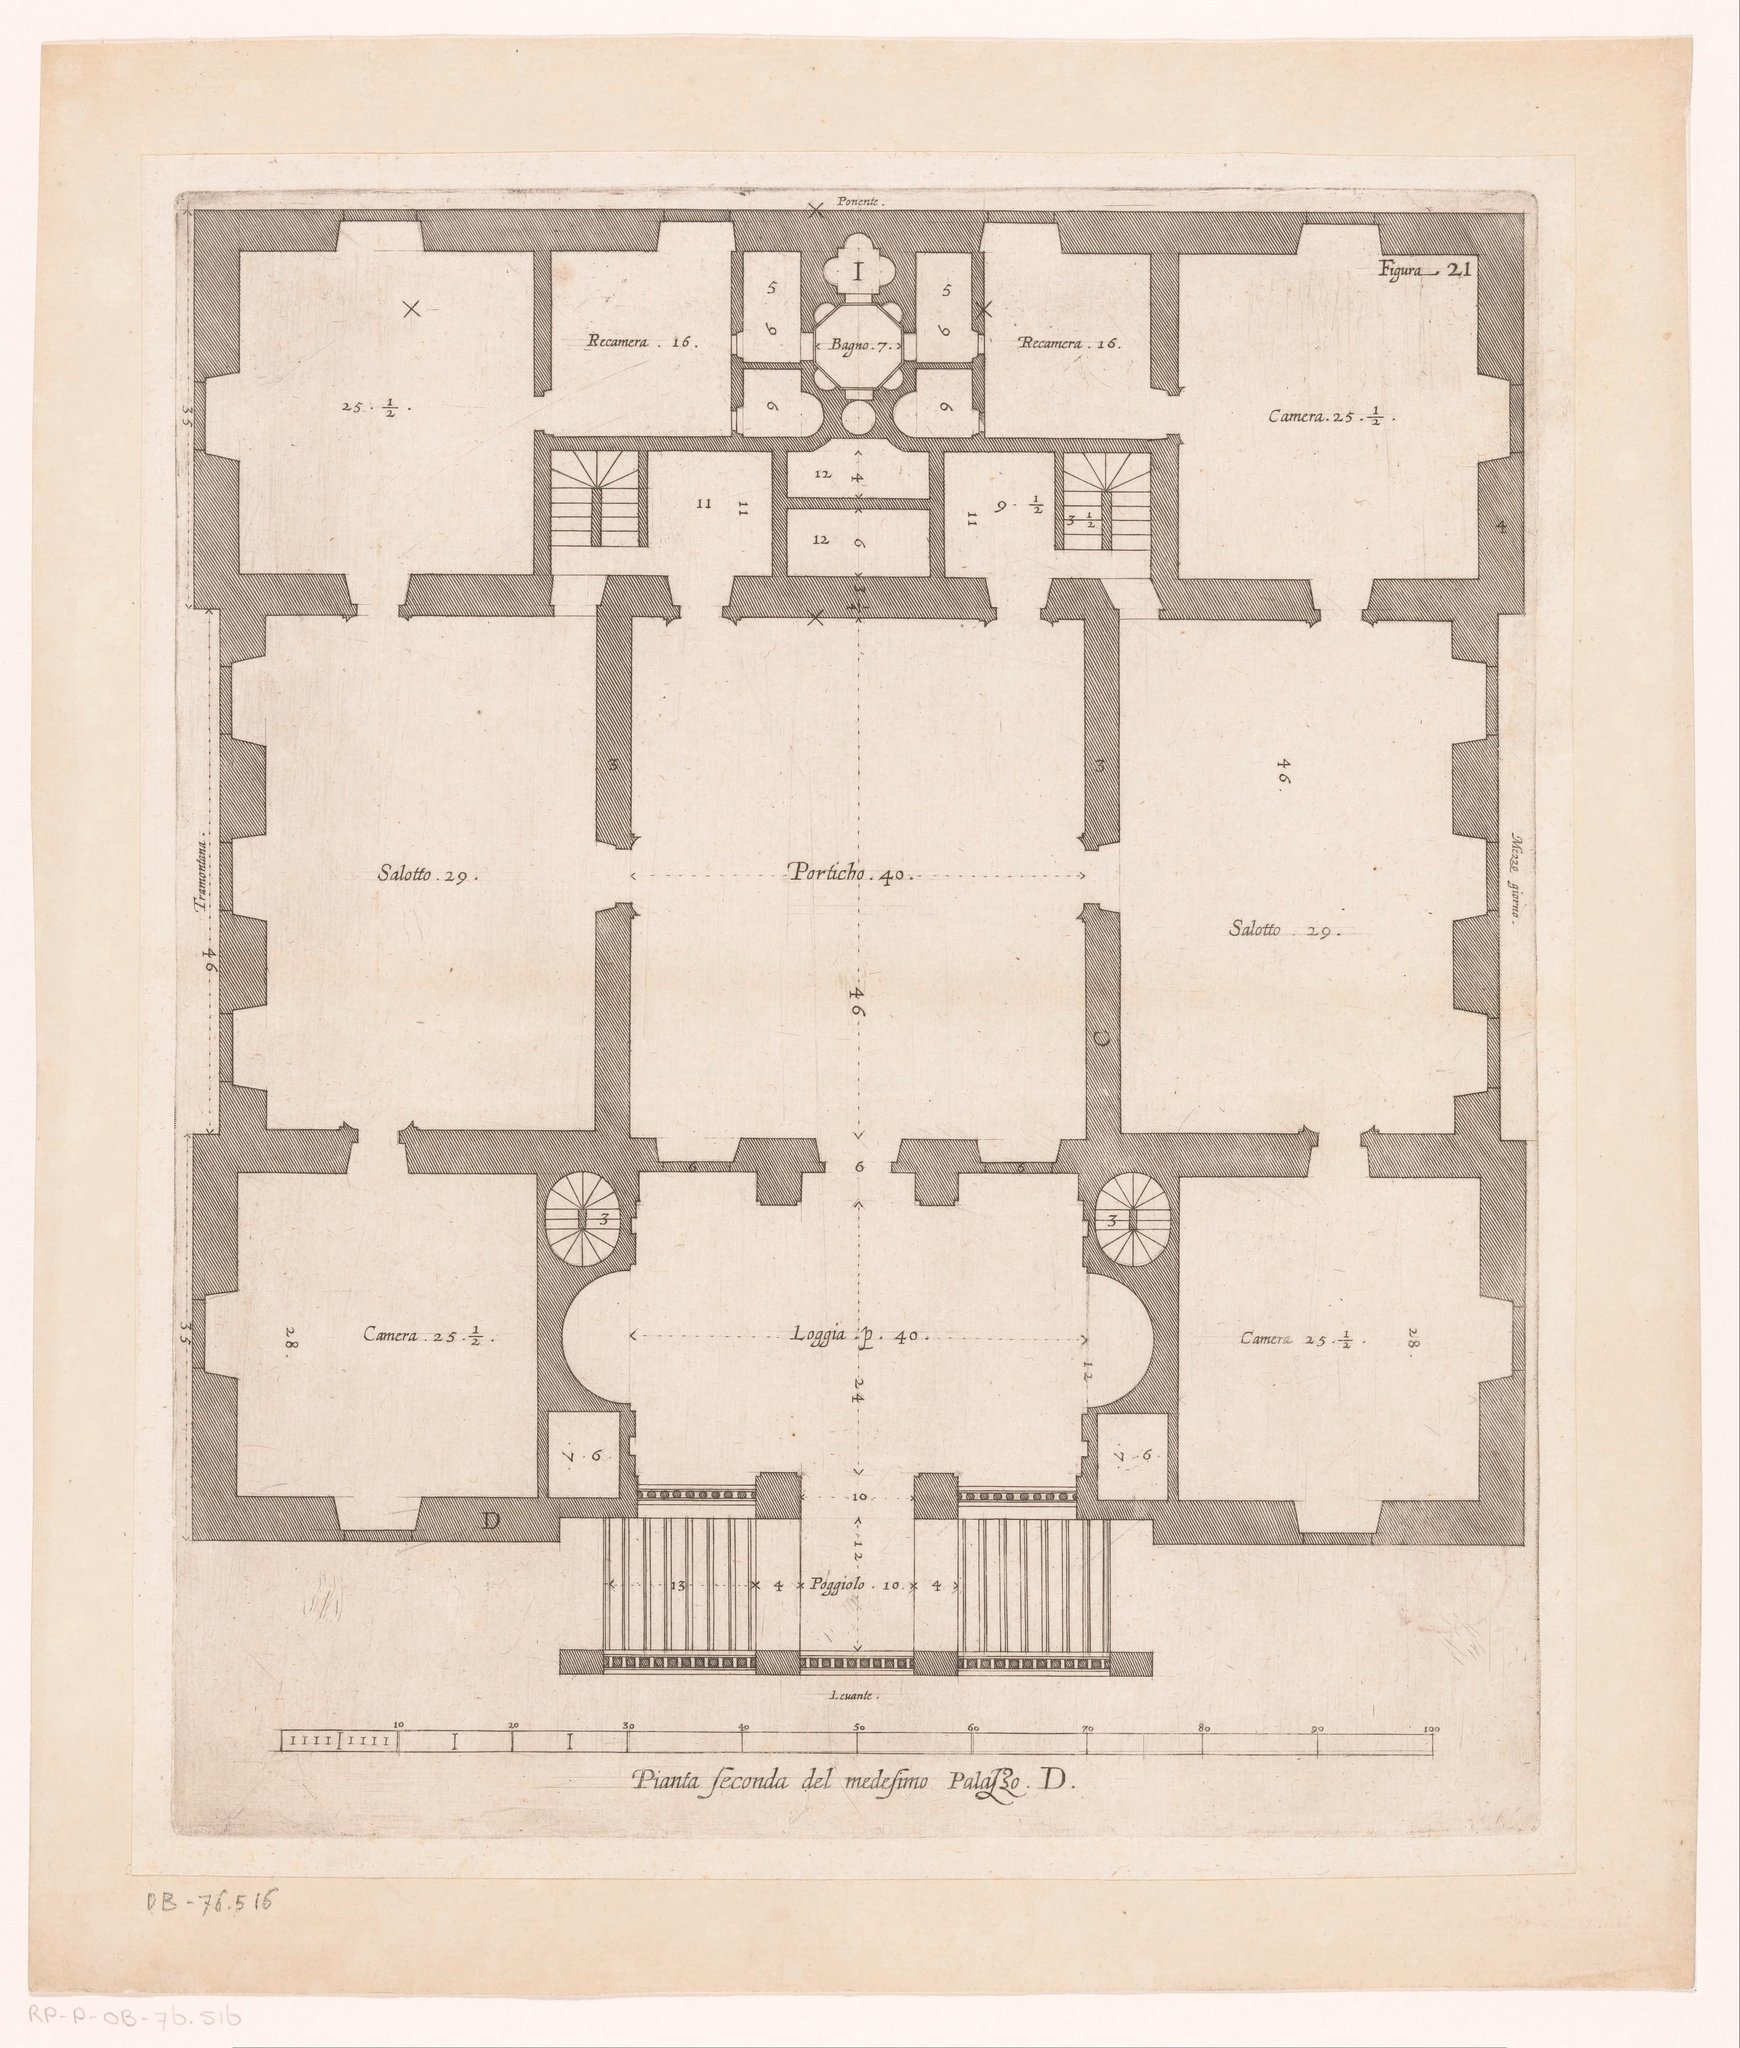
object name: ornament print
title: Palazzi di Genova / Palazzi Antichi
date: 1622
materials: paper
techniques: engraving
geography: antwerp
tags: hôtel, i.e. small palace in city - aa - civic architecture: inside, plan ~ architecture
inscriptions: collector's mark: Lugt 240